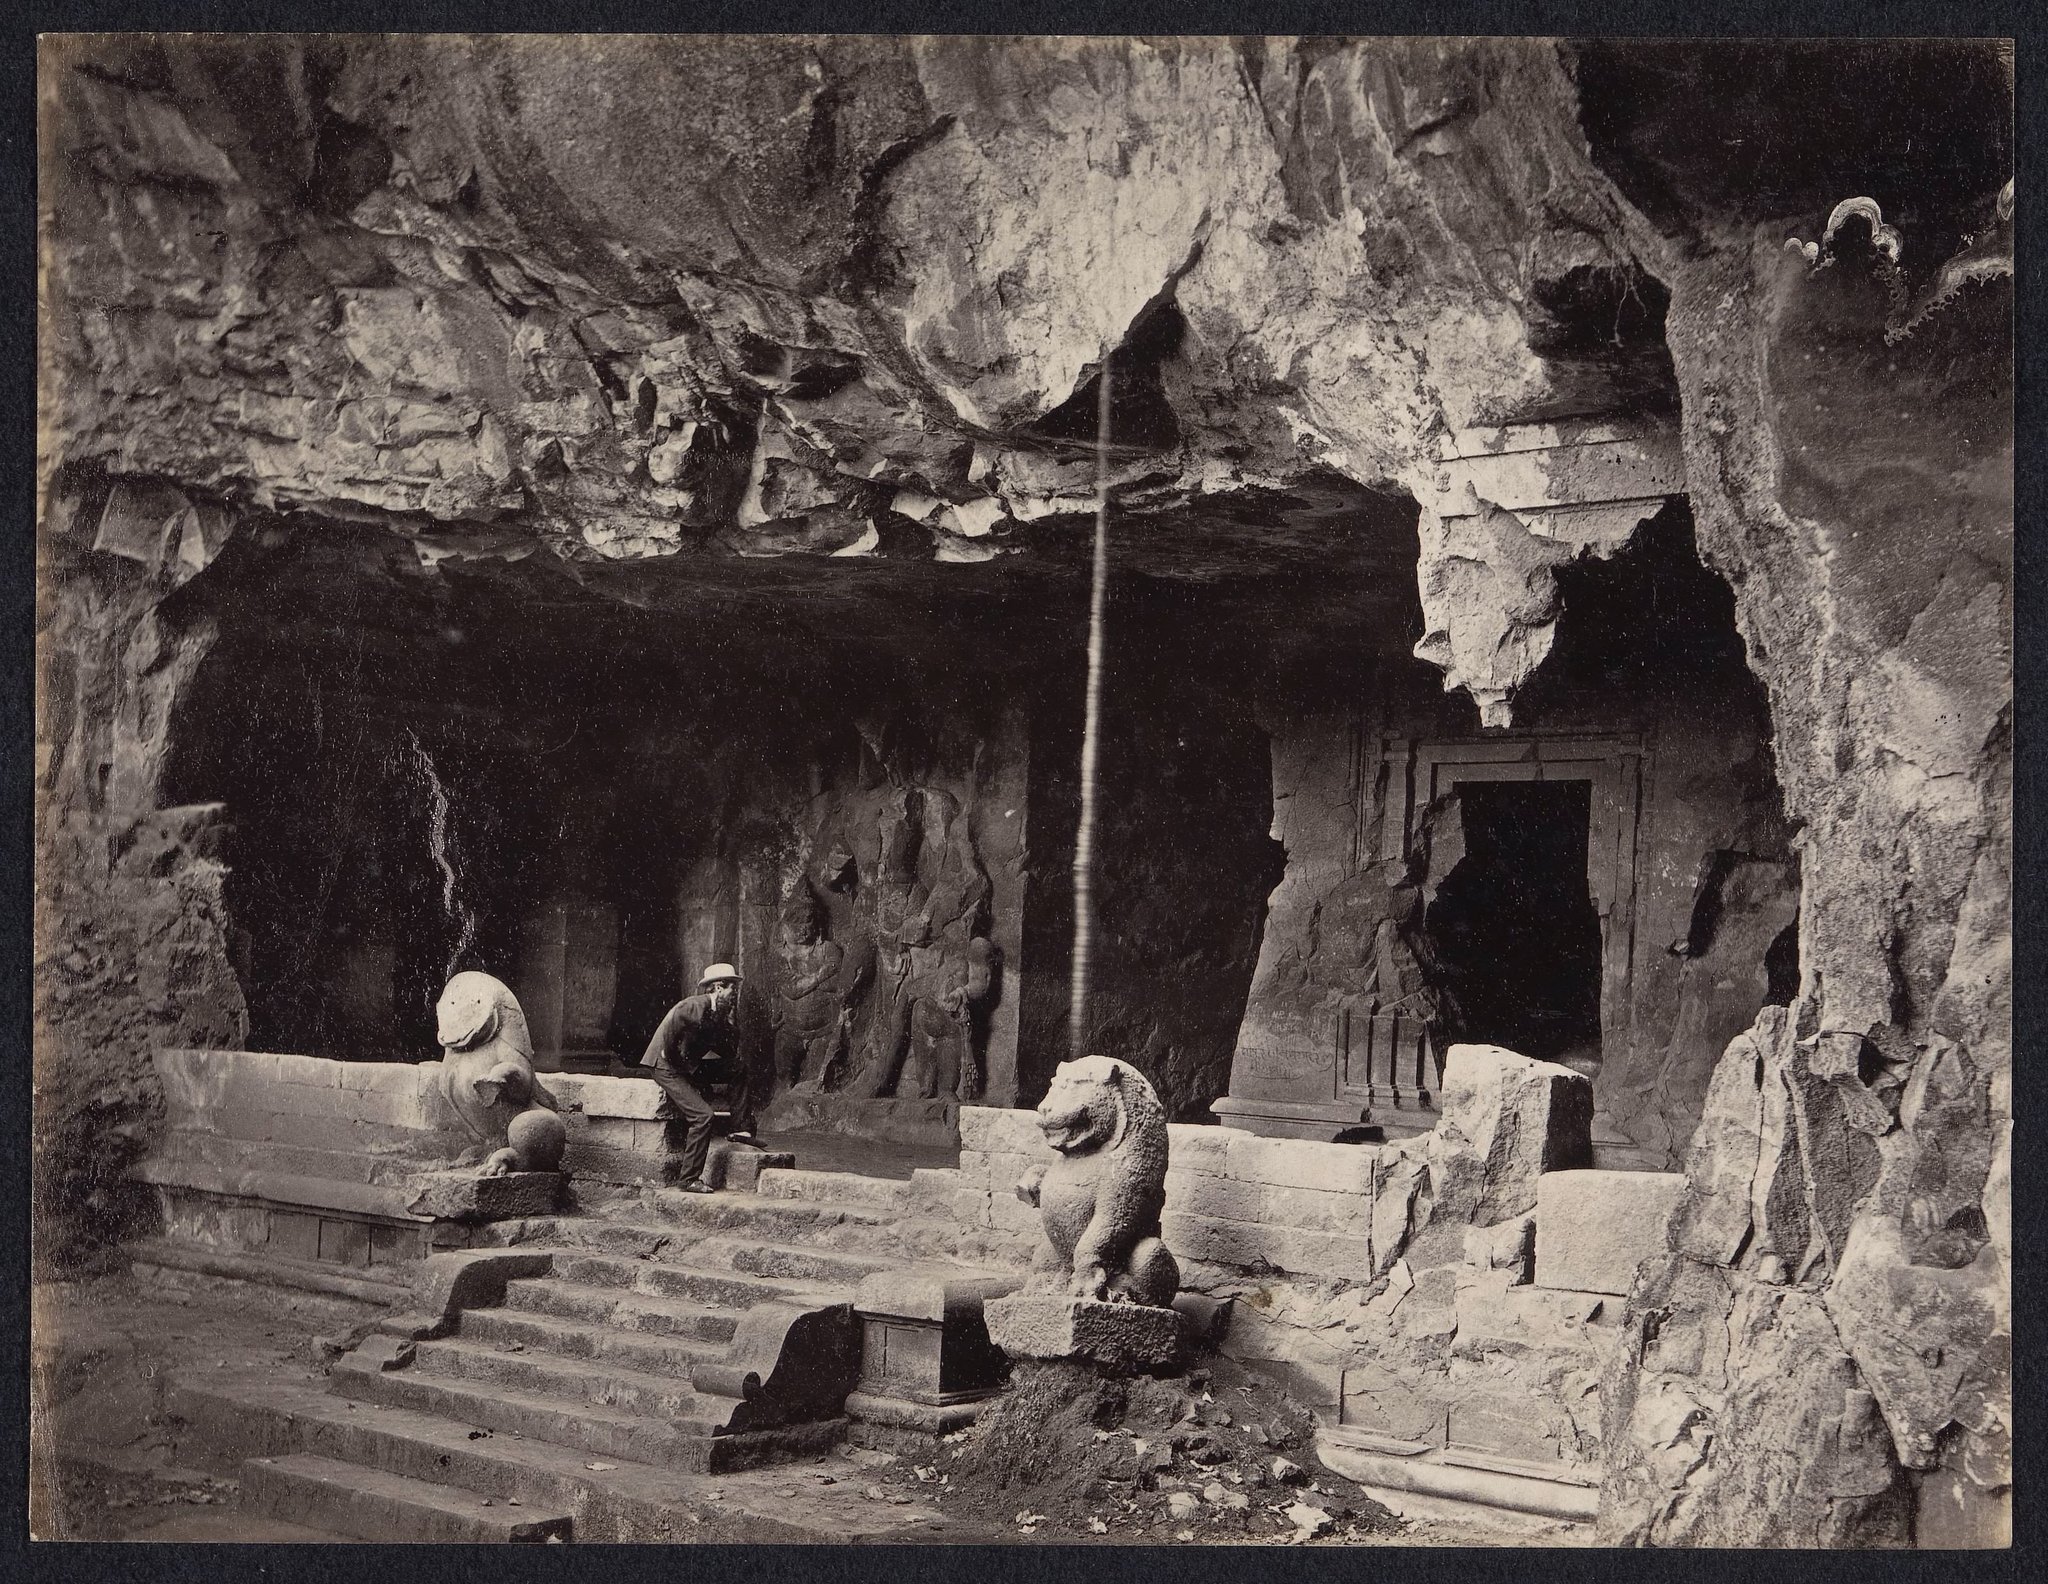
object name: photograph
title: Temple entrance of the Elephanta caves near Mumbai, Maharashtra India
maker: william johnson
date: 1848-1868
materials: paper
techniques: albumen print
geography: great britain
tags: temple, shrine ~ hinduism, buddhism, jainism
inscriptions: number: ‘2/ 3015’, inscription: ‘Bombay/ Eastern Cave of Elephanta’